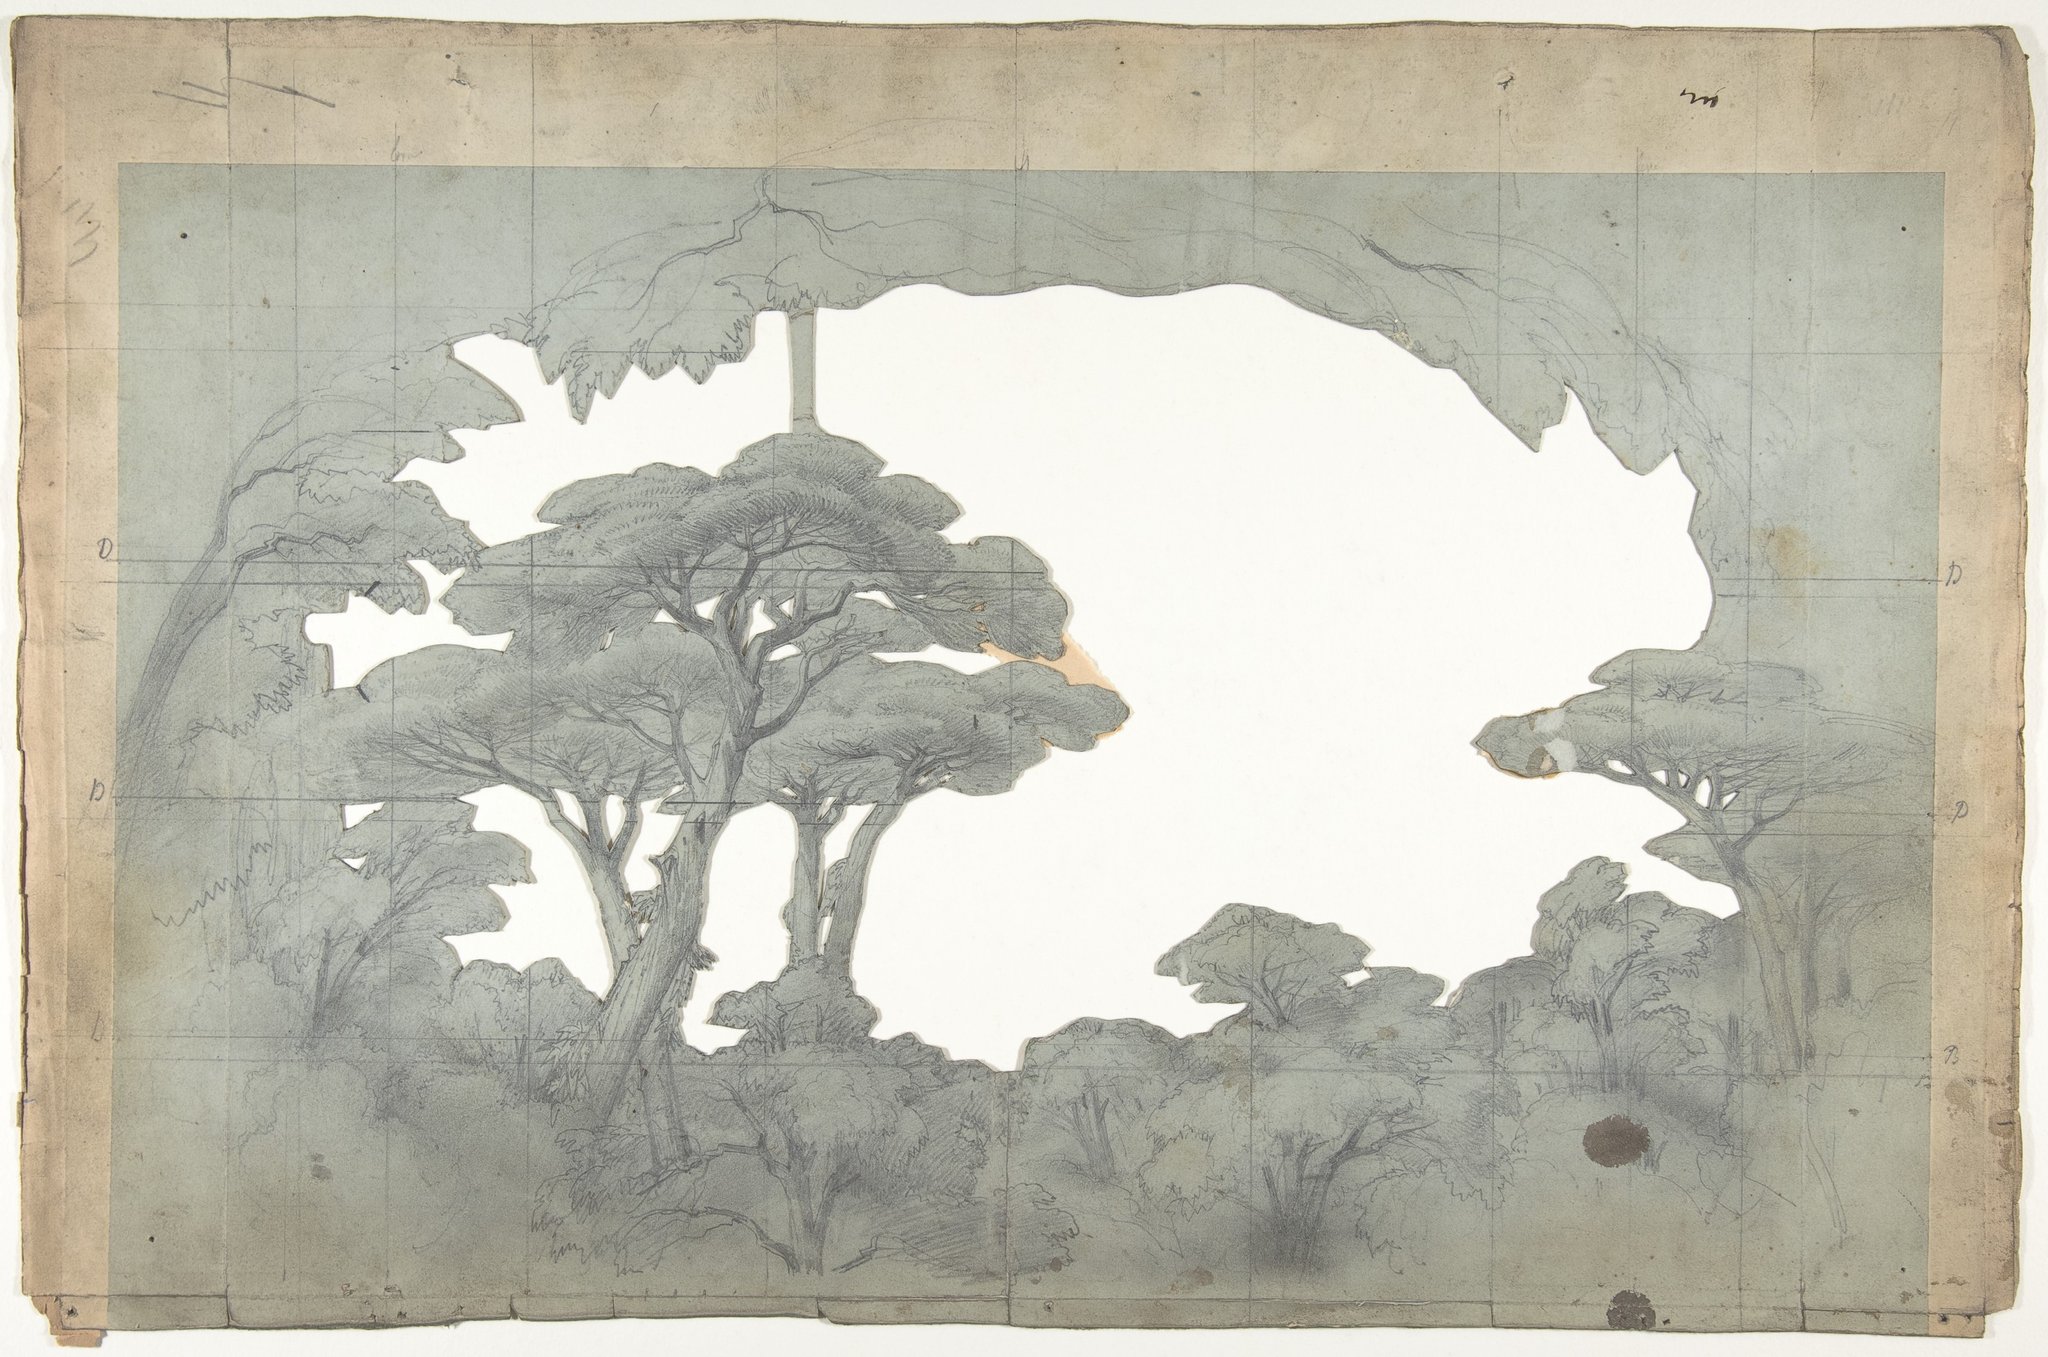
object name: drawing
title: Design for a Stage Set at the Opéra, Paris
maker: eugène cicéri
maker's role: artist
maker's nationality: french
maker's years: 1813-1890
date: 1825-1890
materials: graphite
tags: trees,stage design